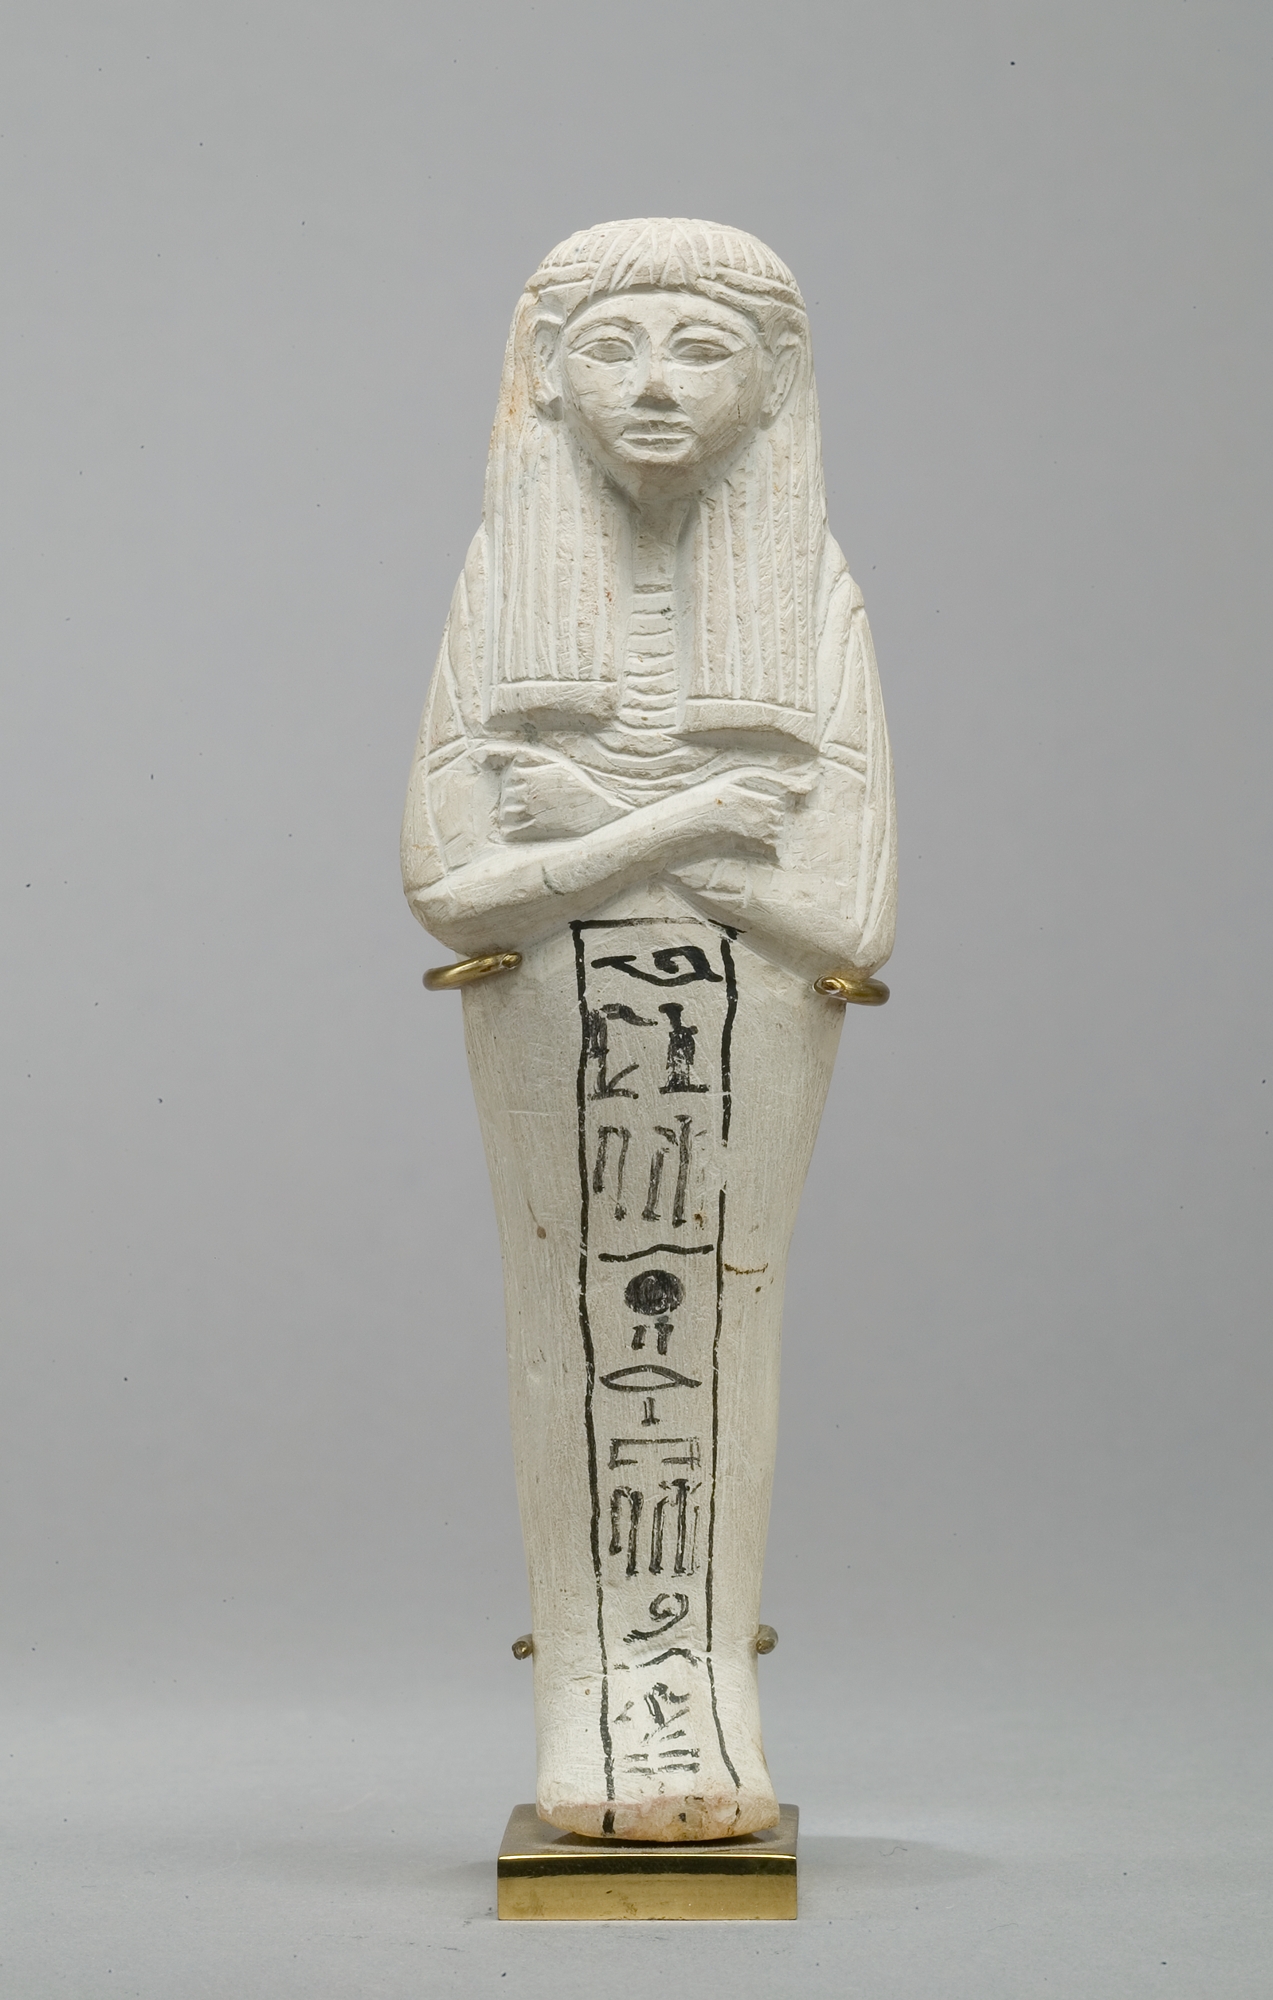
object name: shabti, mose, mesu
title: Shabti of Mesu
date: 1279-1213 BCE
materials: limestone, paint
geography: egypt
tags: hieroglyphs